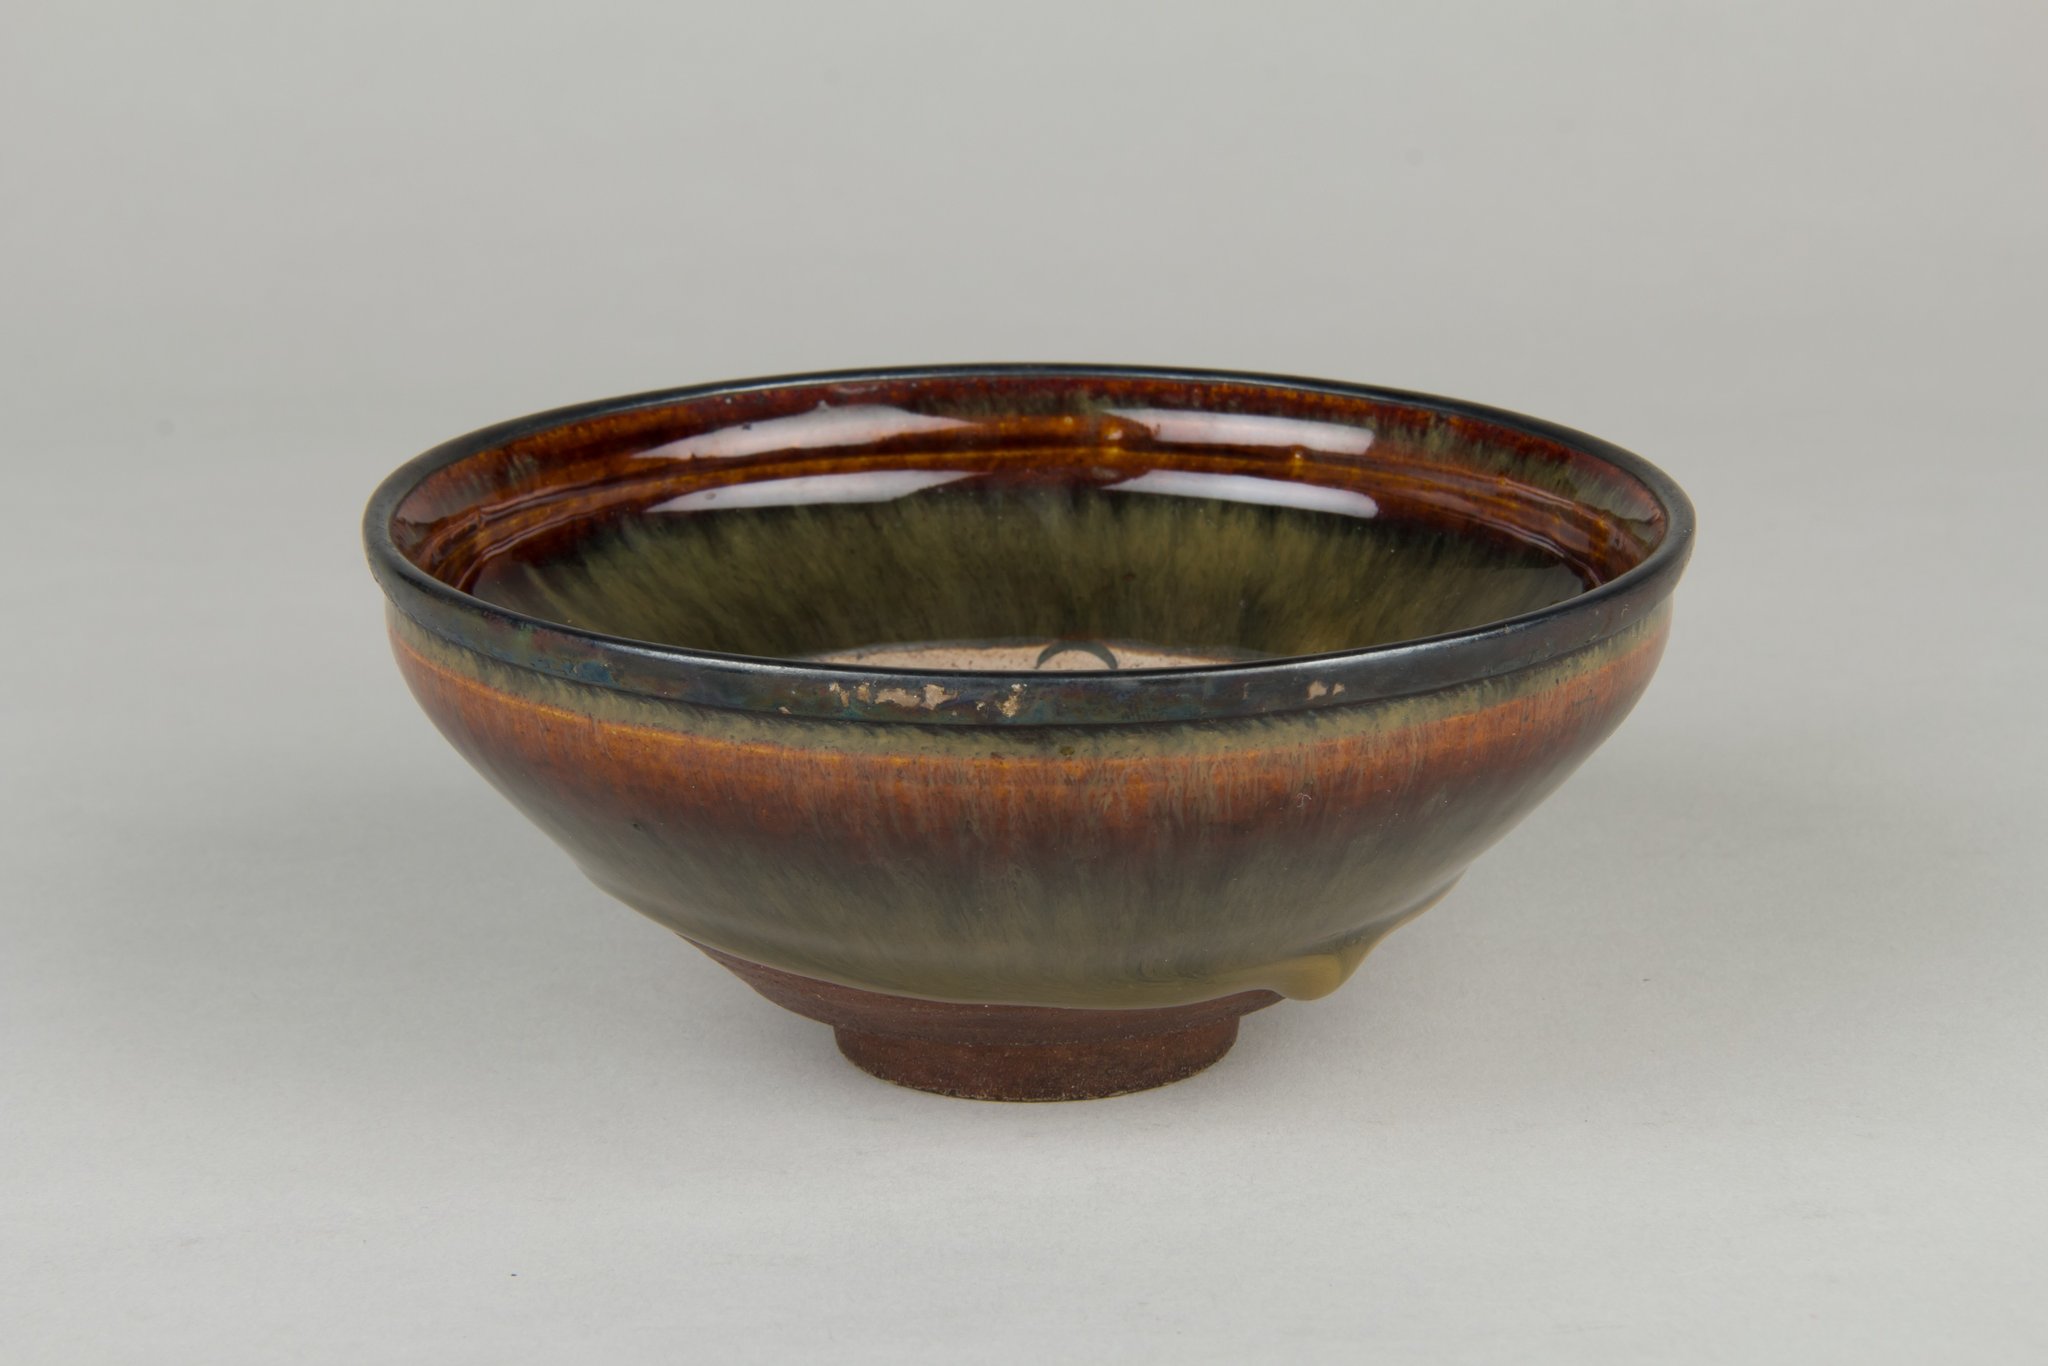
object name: bowl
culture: chinese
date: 960-1279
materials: silver